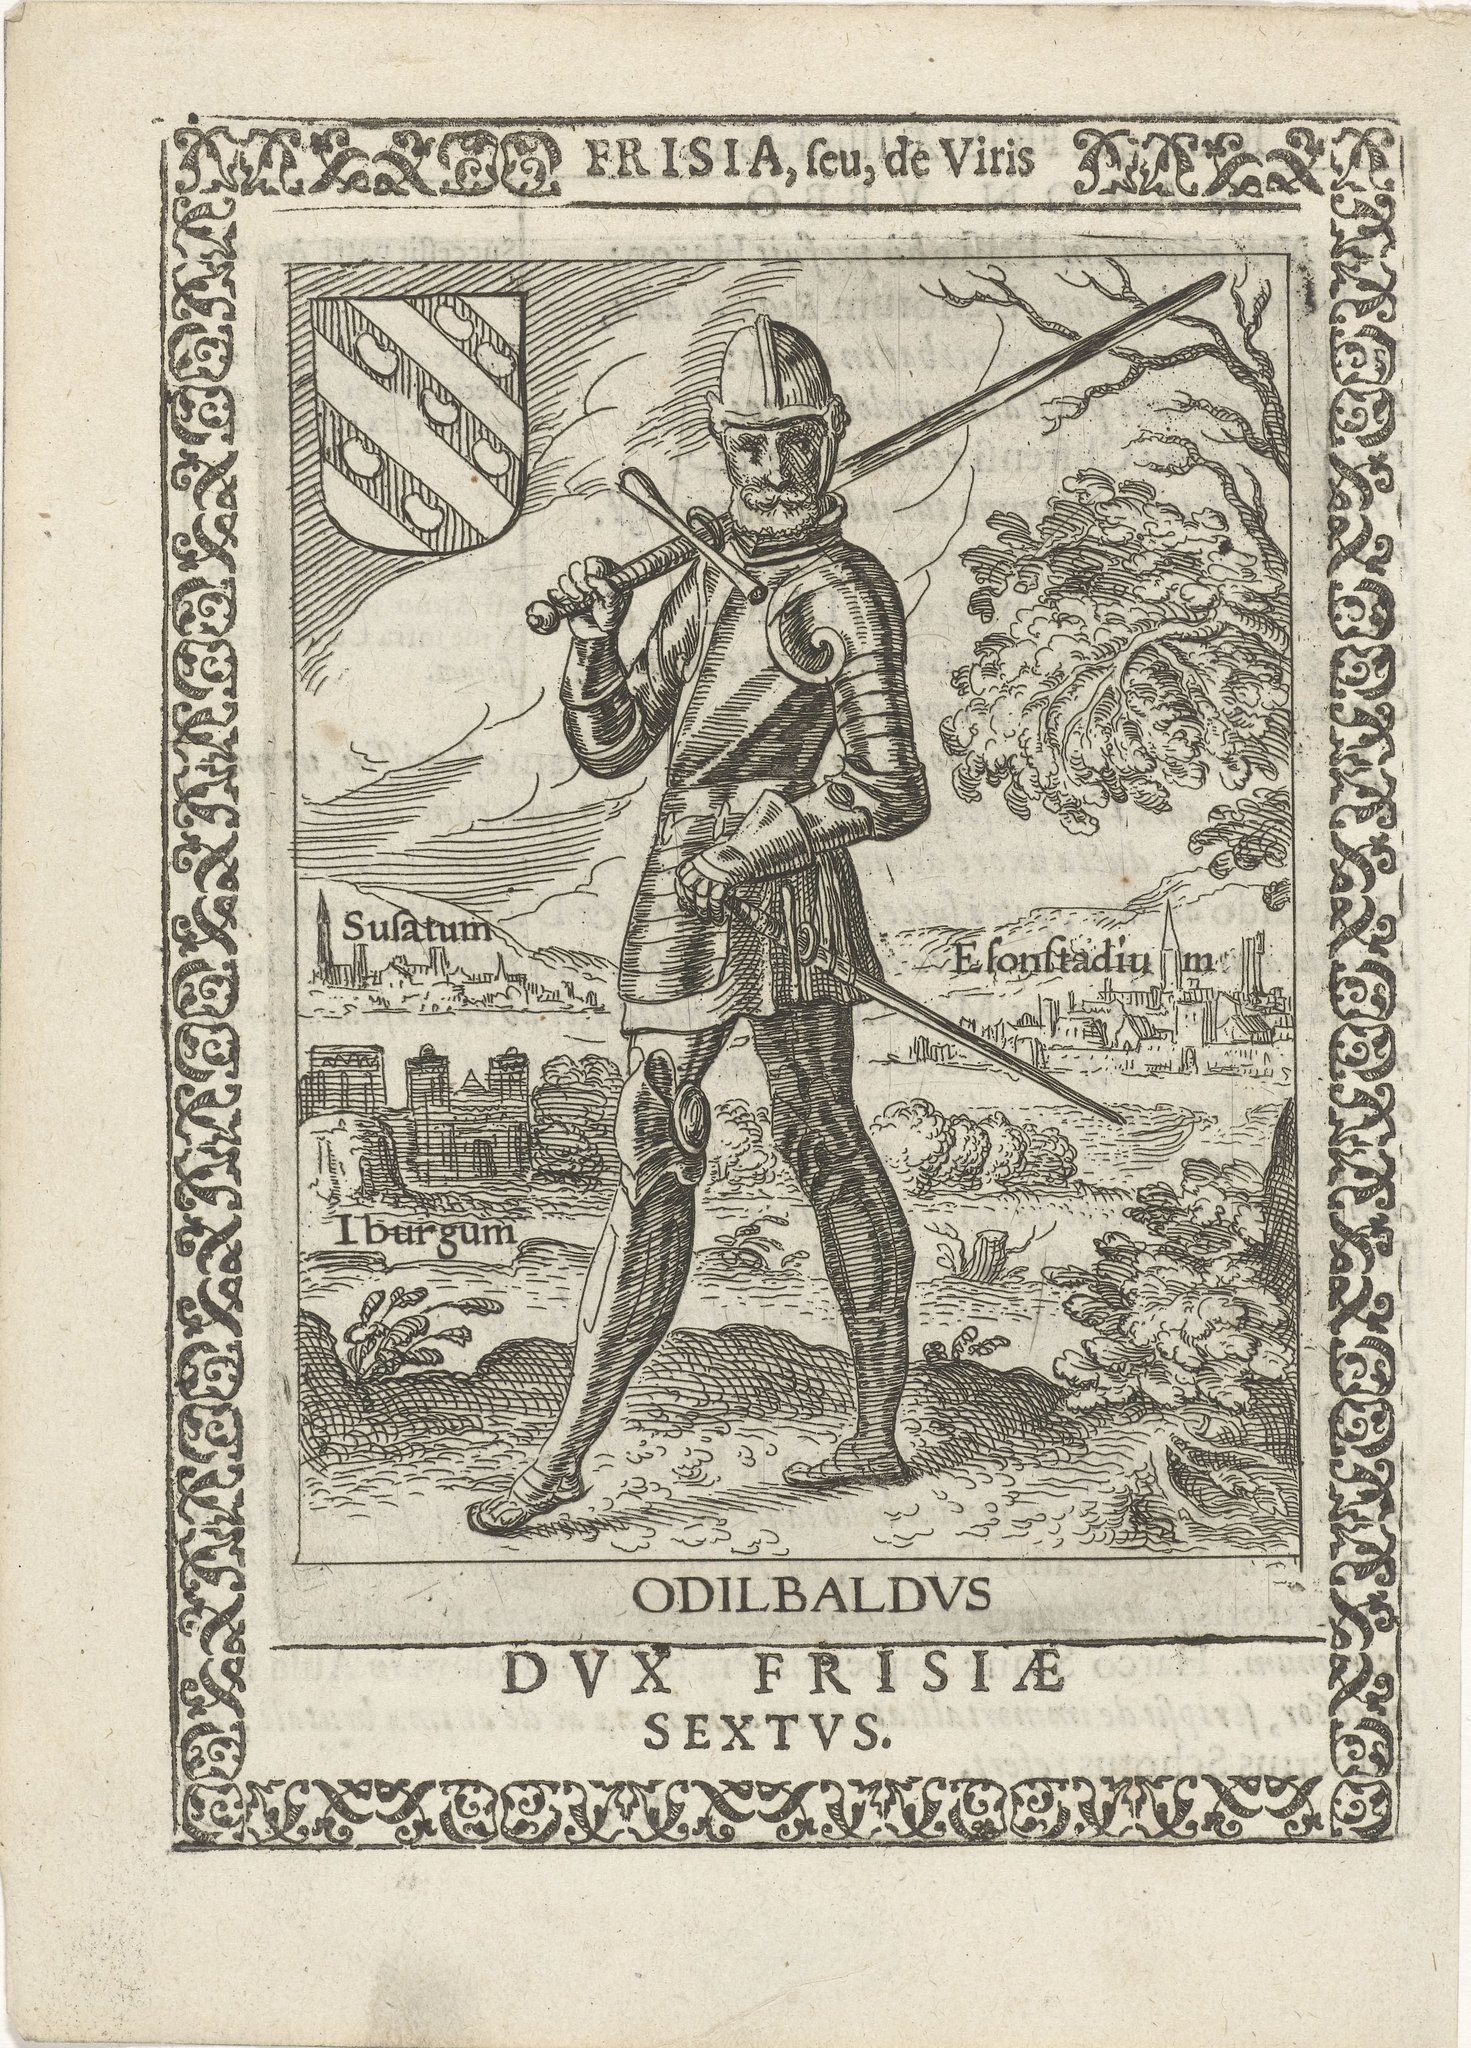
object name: book illustration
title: Odilbald, zesde hertog der Friezen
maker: pieter feddes van harlingen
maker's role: painter, print maker, publisher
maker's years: 1586-1623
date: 1618-1620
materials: paper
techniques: etching, letterpress printing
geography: friesland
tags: ruler, sovereign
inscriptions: collector's mark: Lugt 2228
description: Odilbald, zesde hertog der Friezen. Staande ten voeten uit, zwaard over de schouder. Op de achtergrond verschillende steden. In een ornamentale omlijsting. Illustratie, met tekst op achterzijde, afkomstig uit het boek: Frisia seu de viris rebusque Frisiae illustribus libri duo.